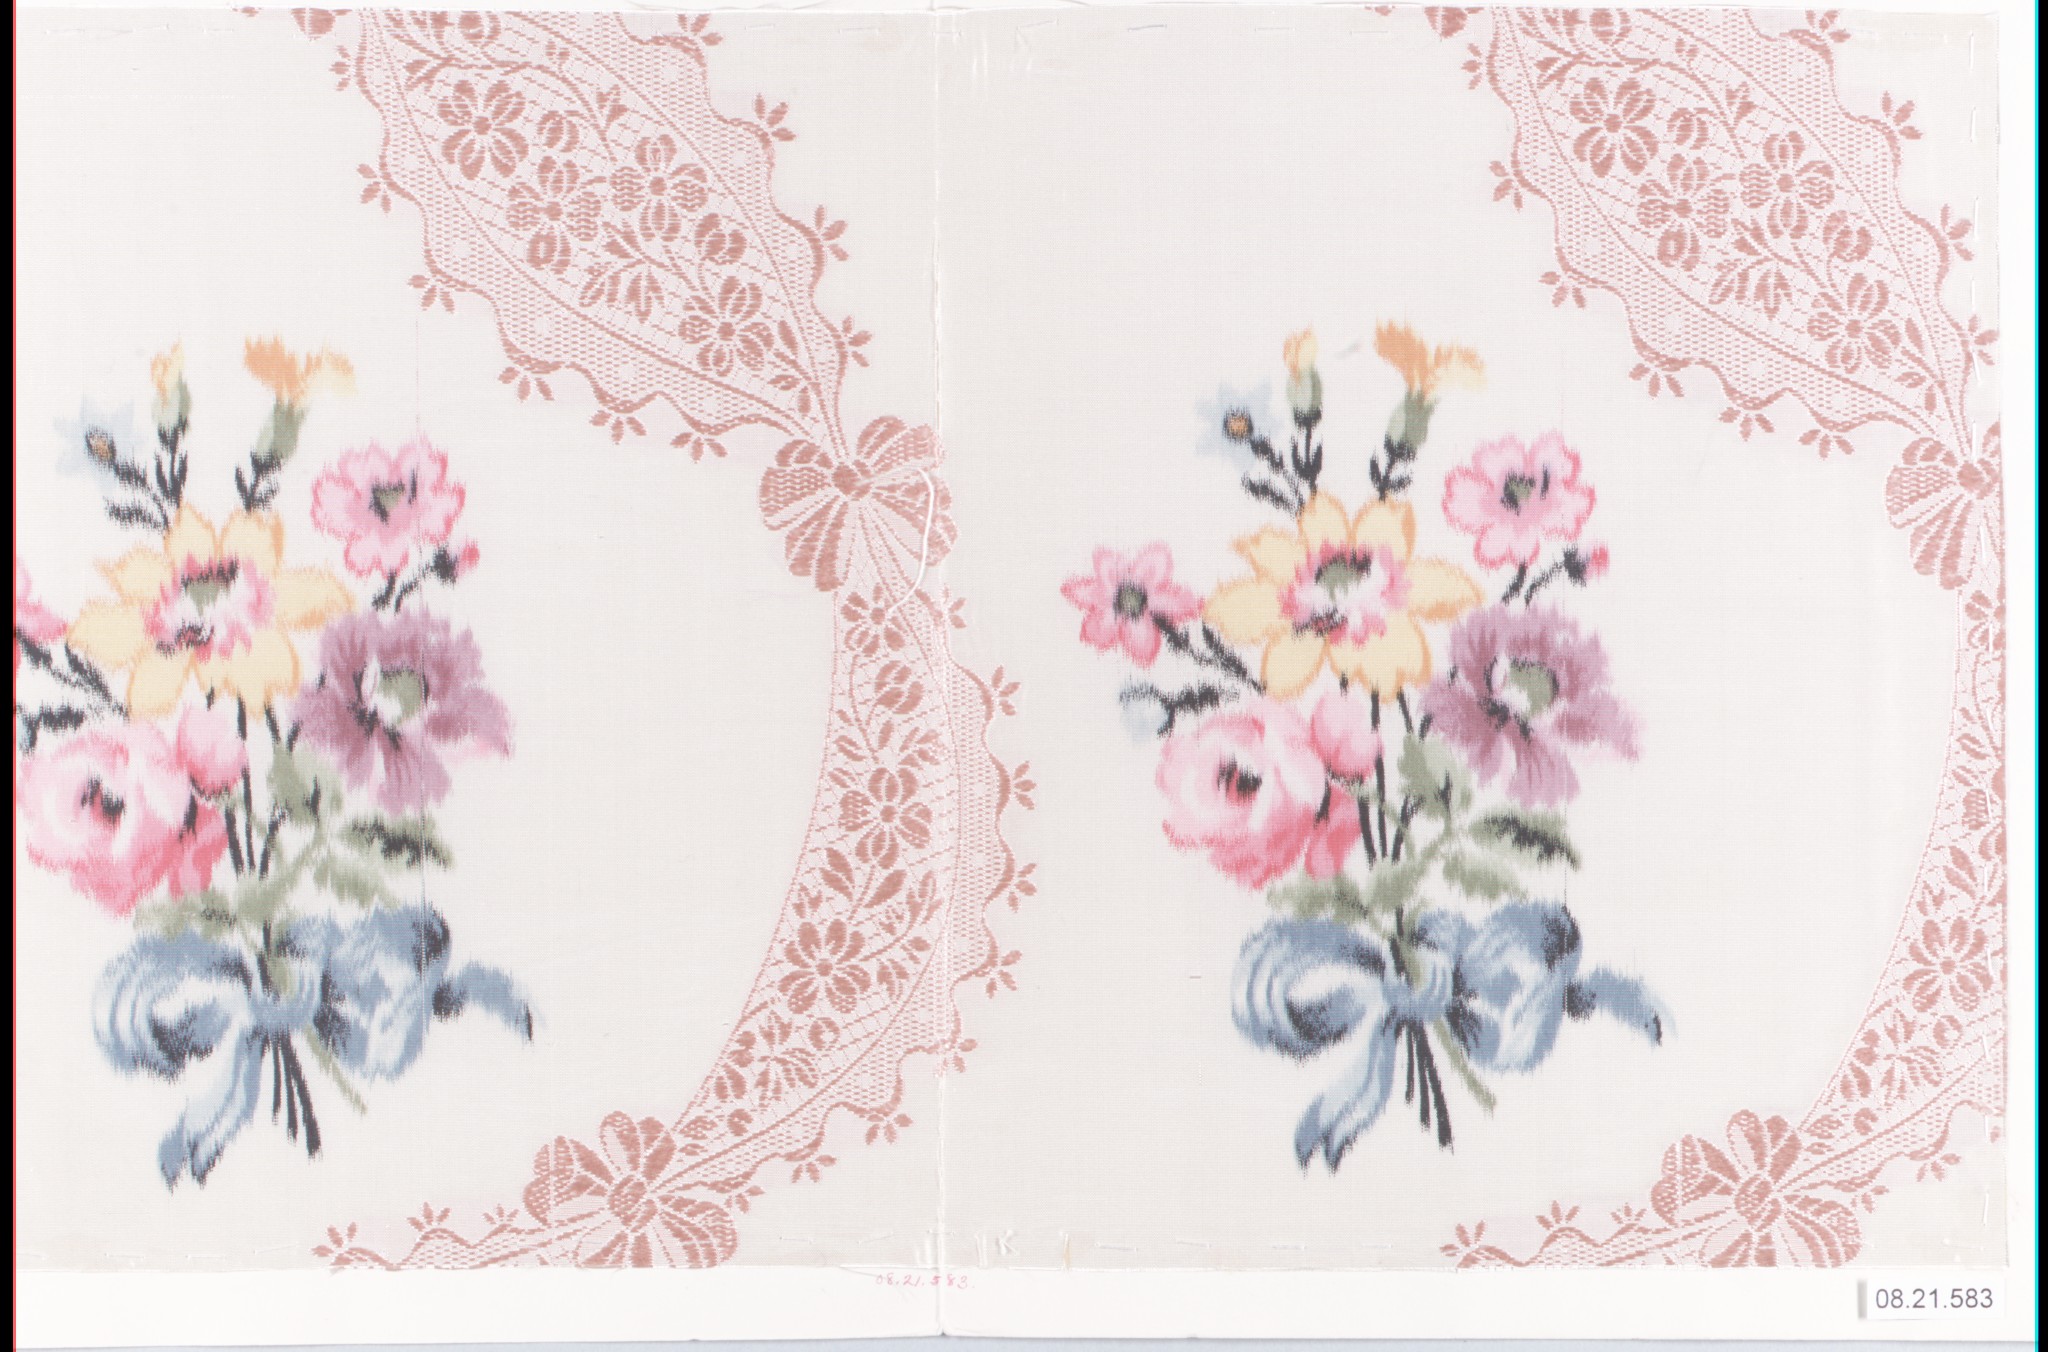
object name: textile sample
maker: Anonymous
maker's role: designer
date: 1900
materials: silk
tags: flowers